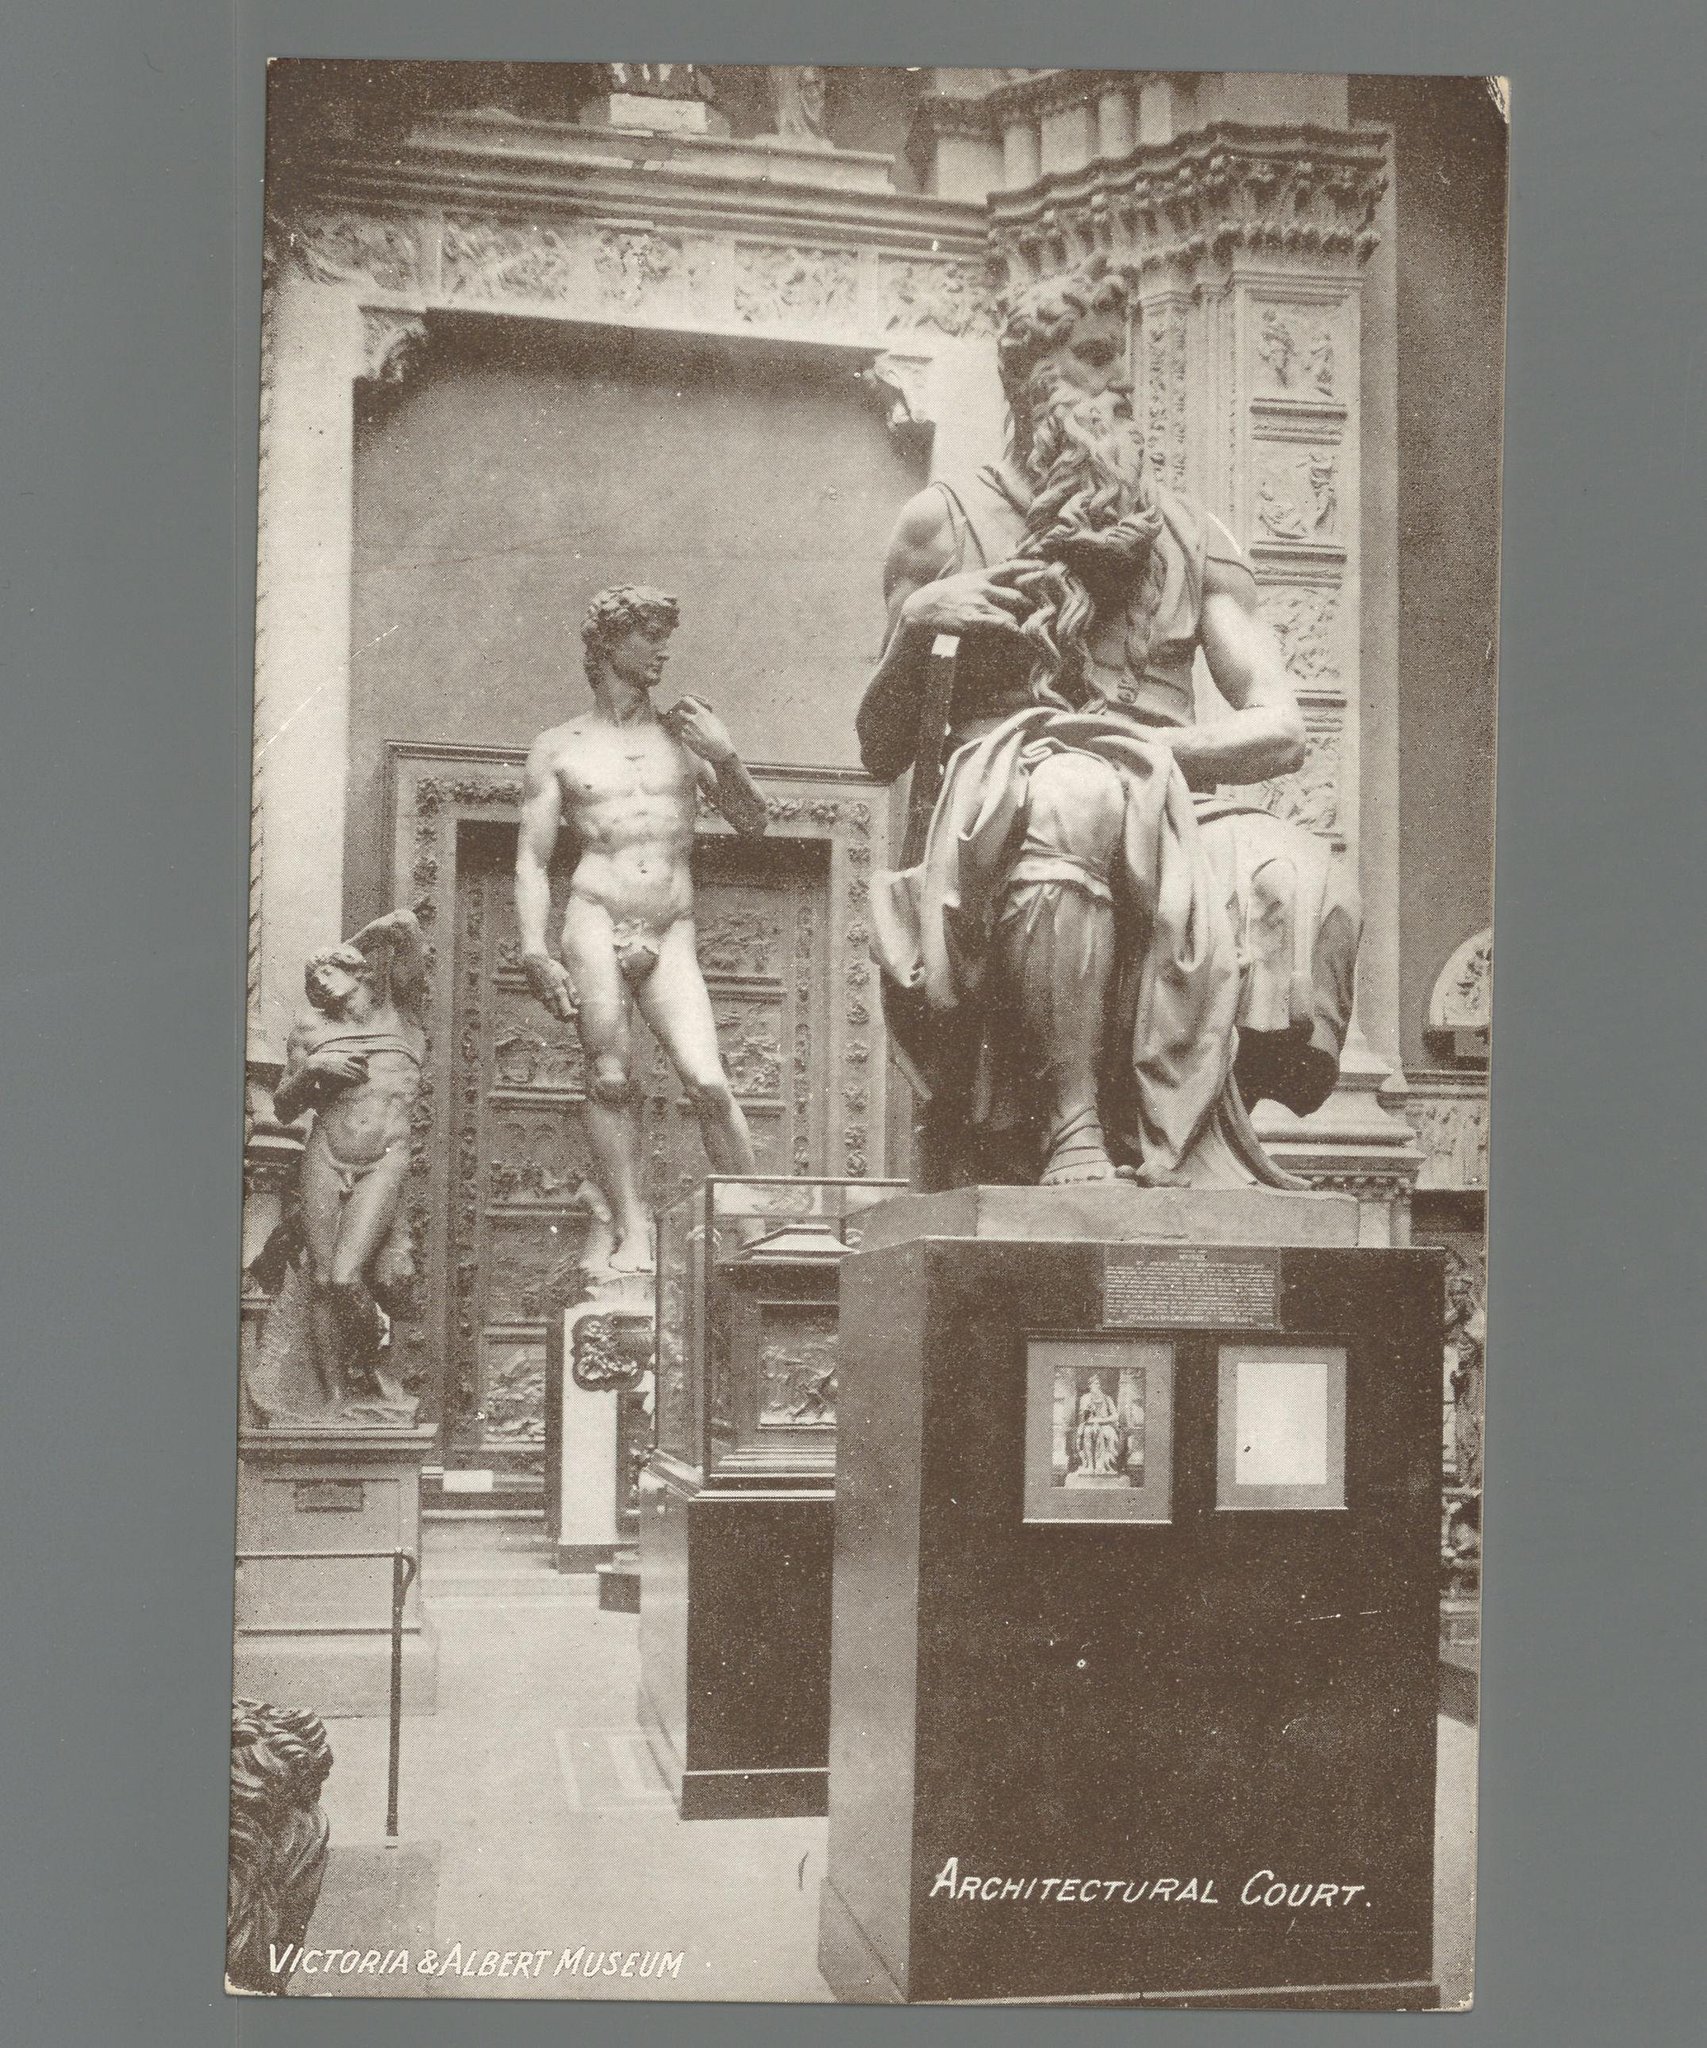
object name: photomechanical print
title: Victoria and Albert Museum (South Kensington) Series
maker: Anonymous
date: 1902-1918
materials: cardboard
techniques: autotype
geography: london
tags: monument, statue, permanent exhibition, museum